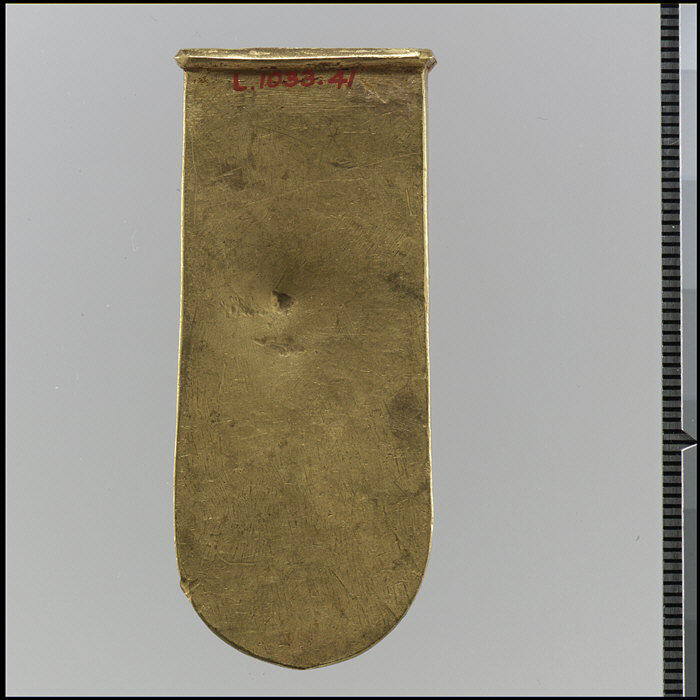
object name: belt strap end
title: Gold Strap End (Unfinished)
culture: avar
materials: gold